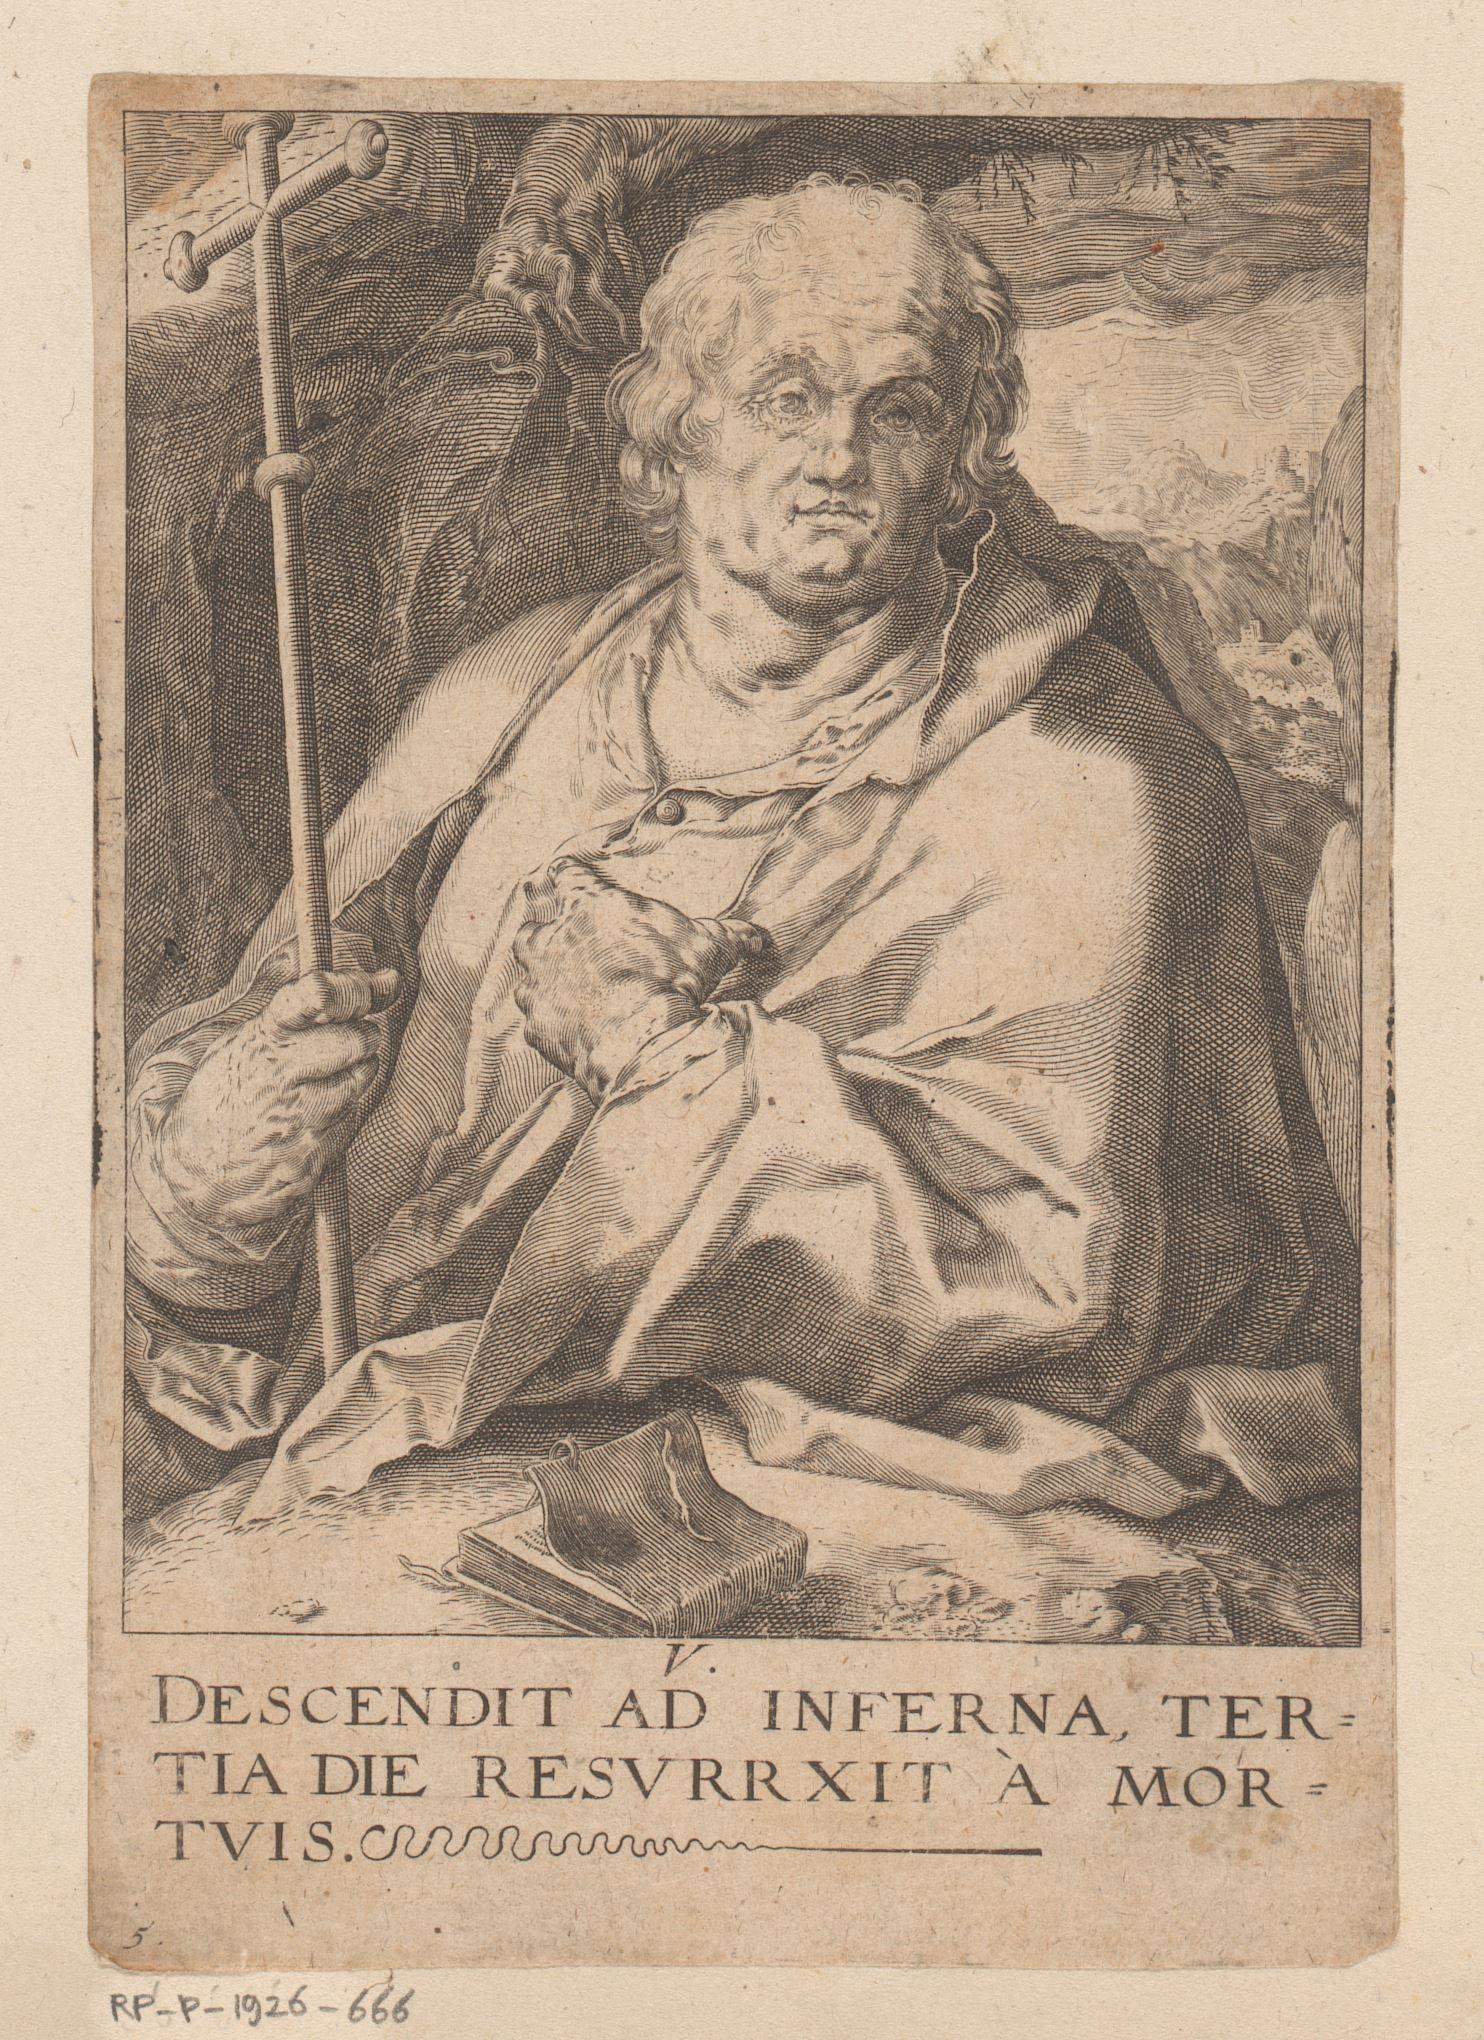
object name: print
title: Apostel Filippus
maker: jacques granthomme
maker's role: print maker, publisher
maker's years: 1550-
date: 1588-1622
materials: paper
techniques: engraving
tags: the apostle philip; possible attributes: book, cross, dish with snake, lance, scroll, stone, sword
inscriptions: collector's mark: Lugt 1432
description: Maakt deel uit van een dertiendelige serie van Christus en de twaalf apostelen naar Hendrick Goltzius.